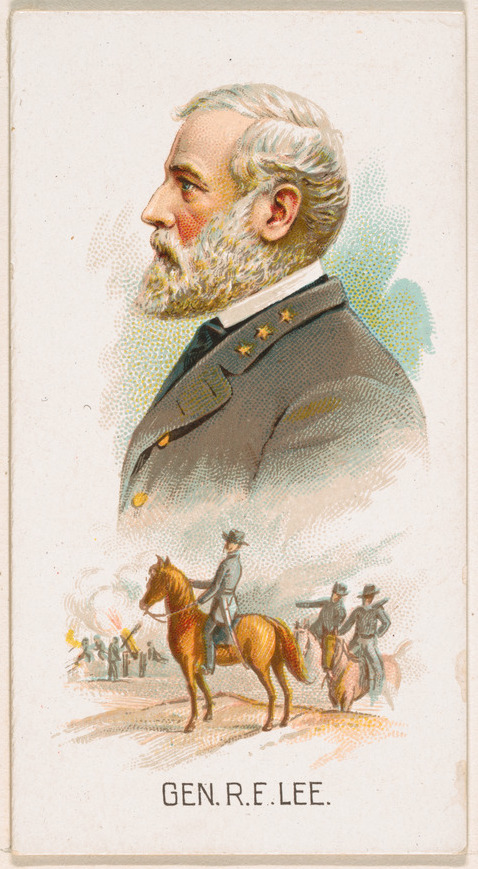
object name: print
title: General Robert E. Lee, from Leaders series (N222) issued by Kinney Bros.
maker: kinney brothers tobacco company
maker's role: publisher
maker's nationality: american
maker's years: 1869-2011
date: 1888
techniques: color lithograph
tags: men,profiles,horses,generals